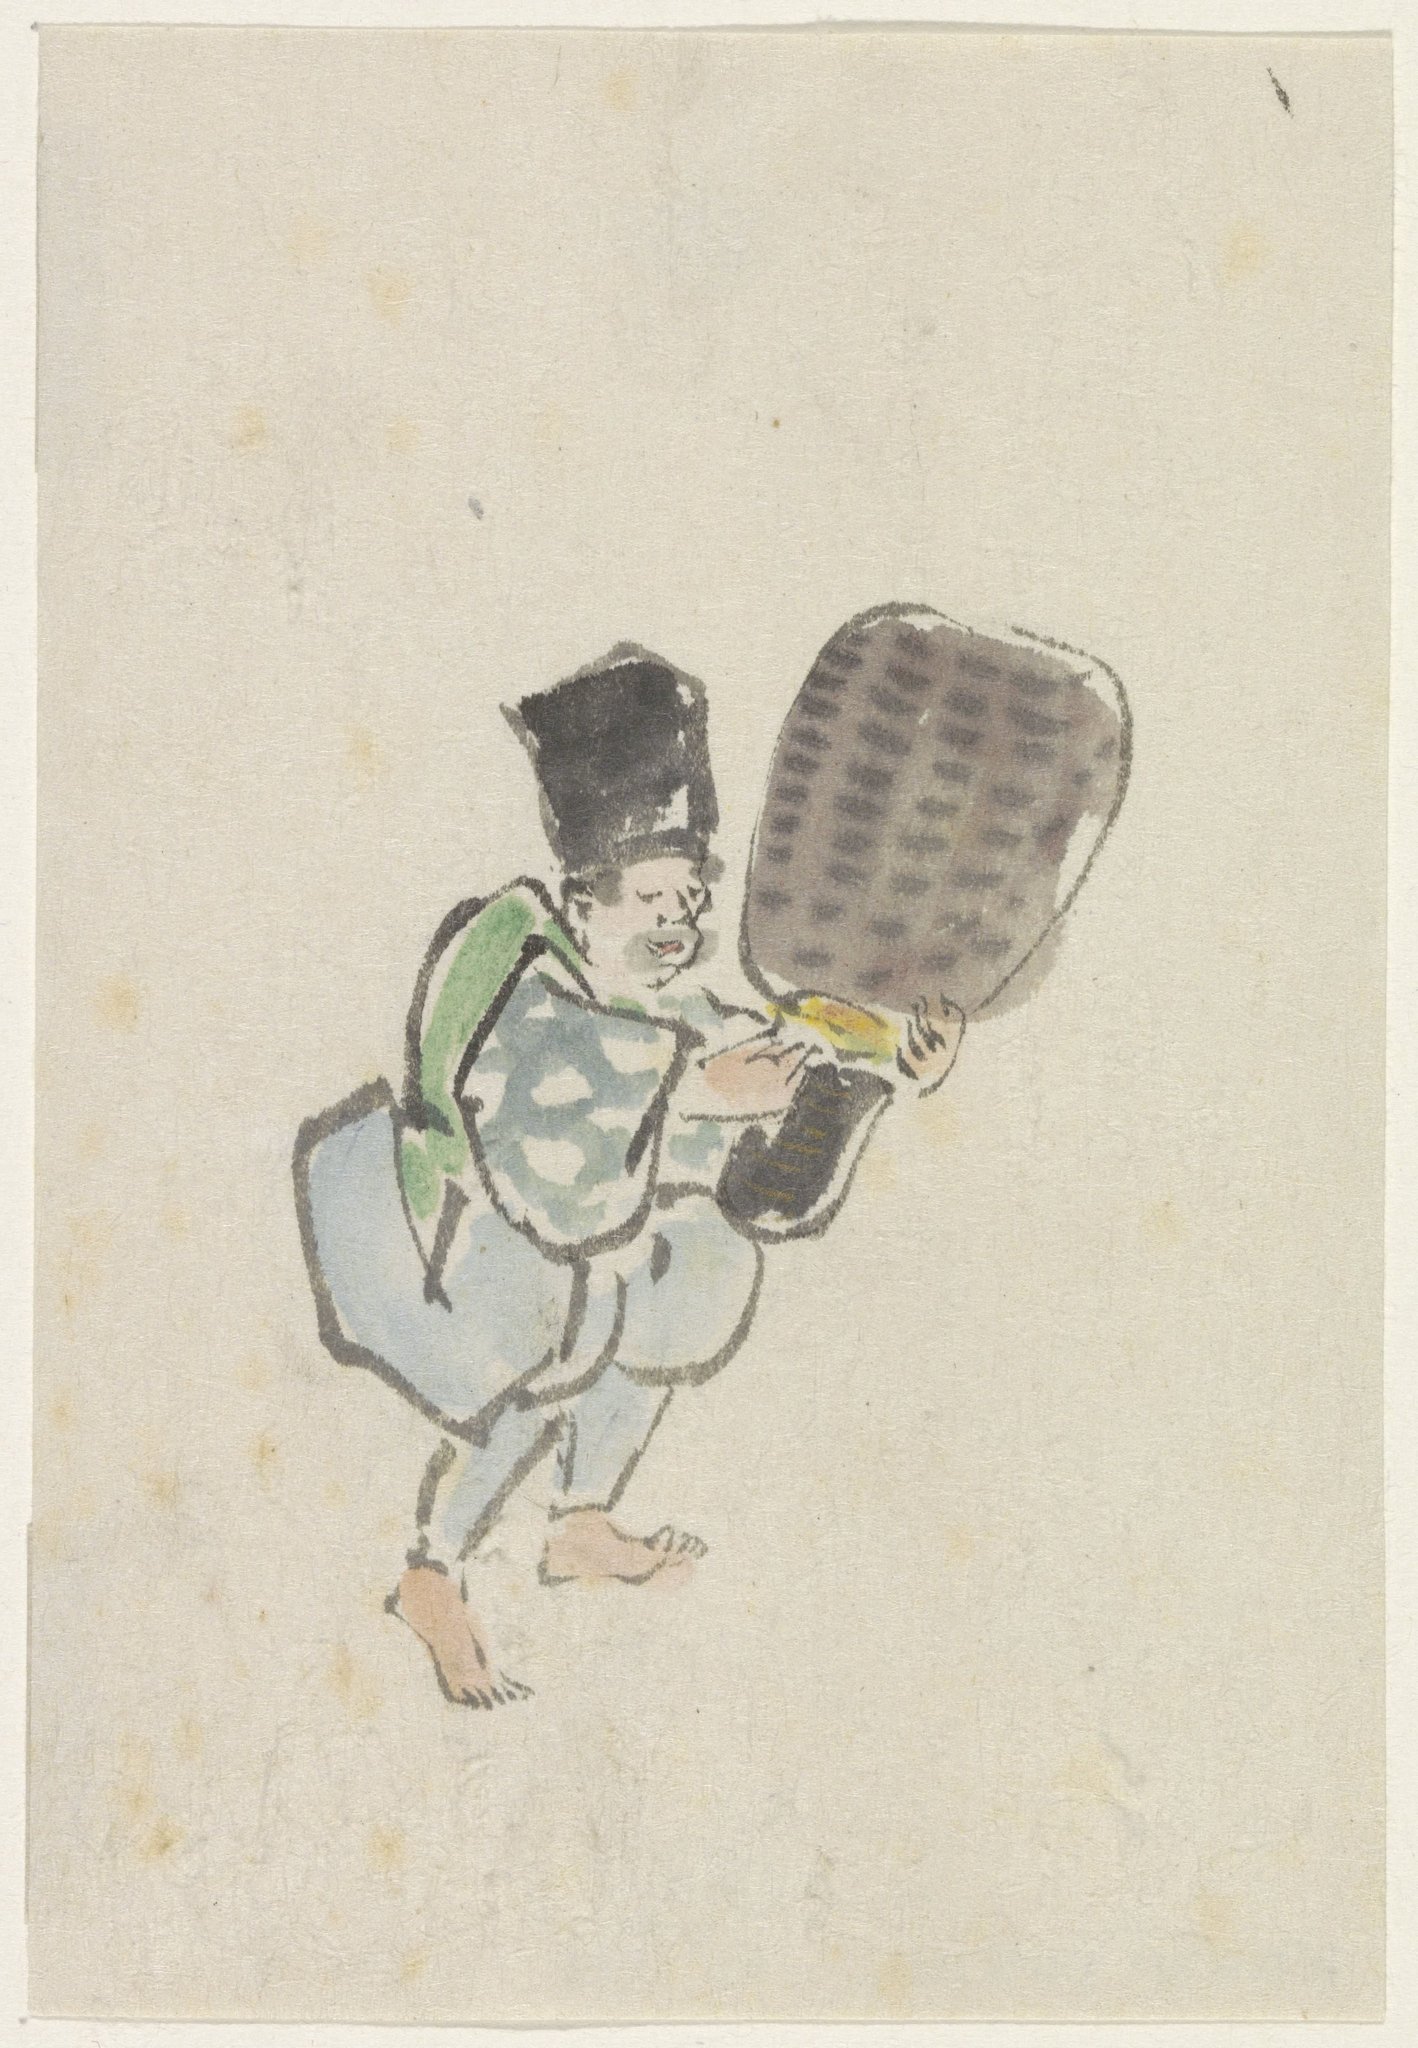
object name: drawing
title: Man met reusachtige waaier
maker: utagawa kuniyoshi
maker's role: draughtsman, print maker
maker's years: 1798-1861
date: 1808-1861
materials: paper, watercolor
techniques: brush